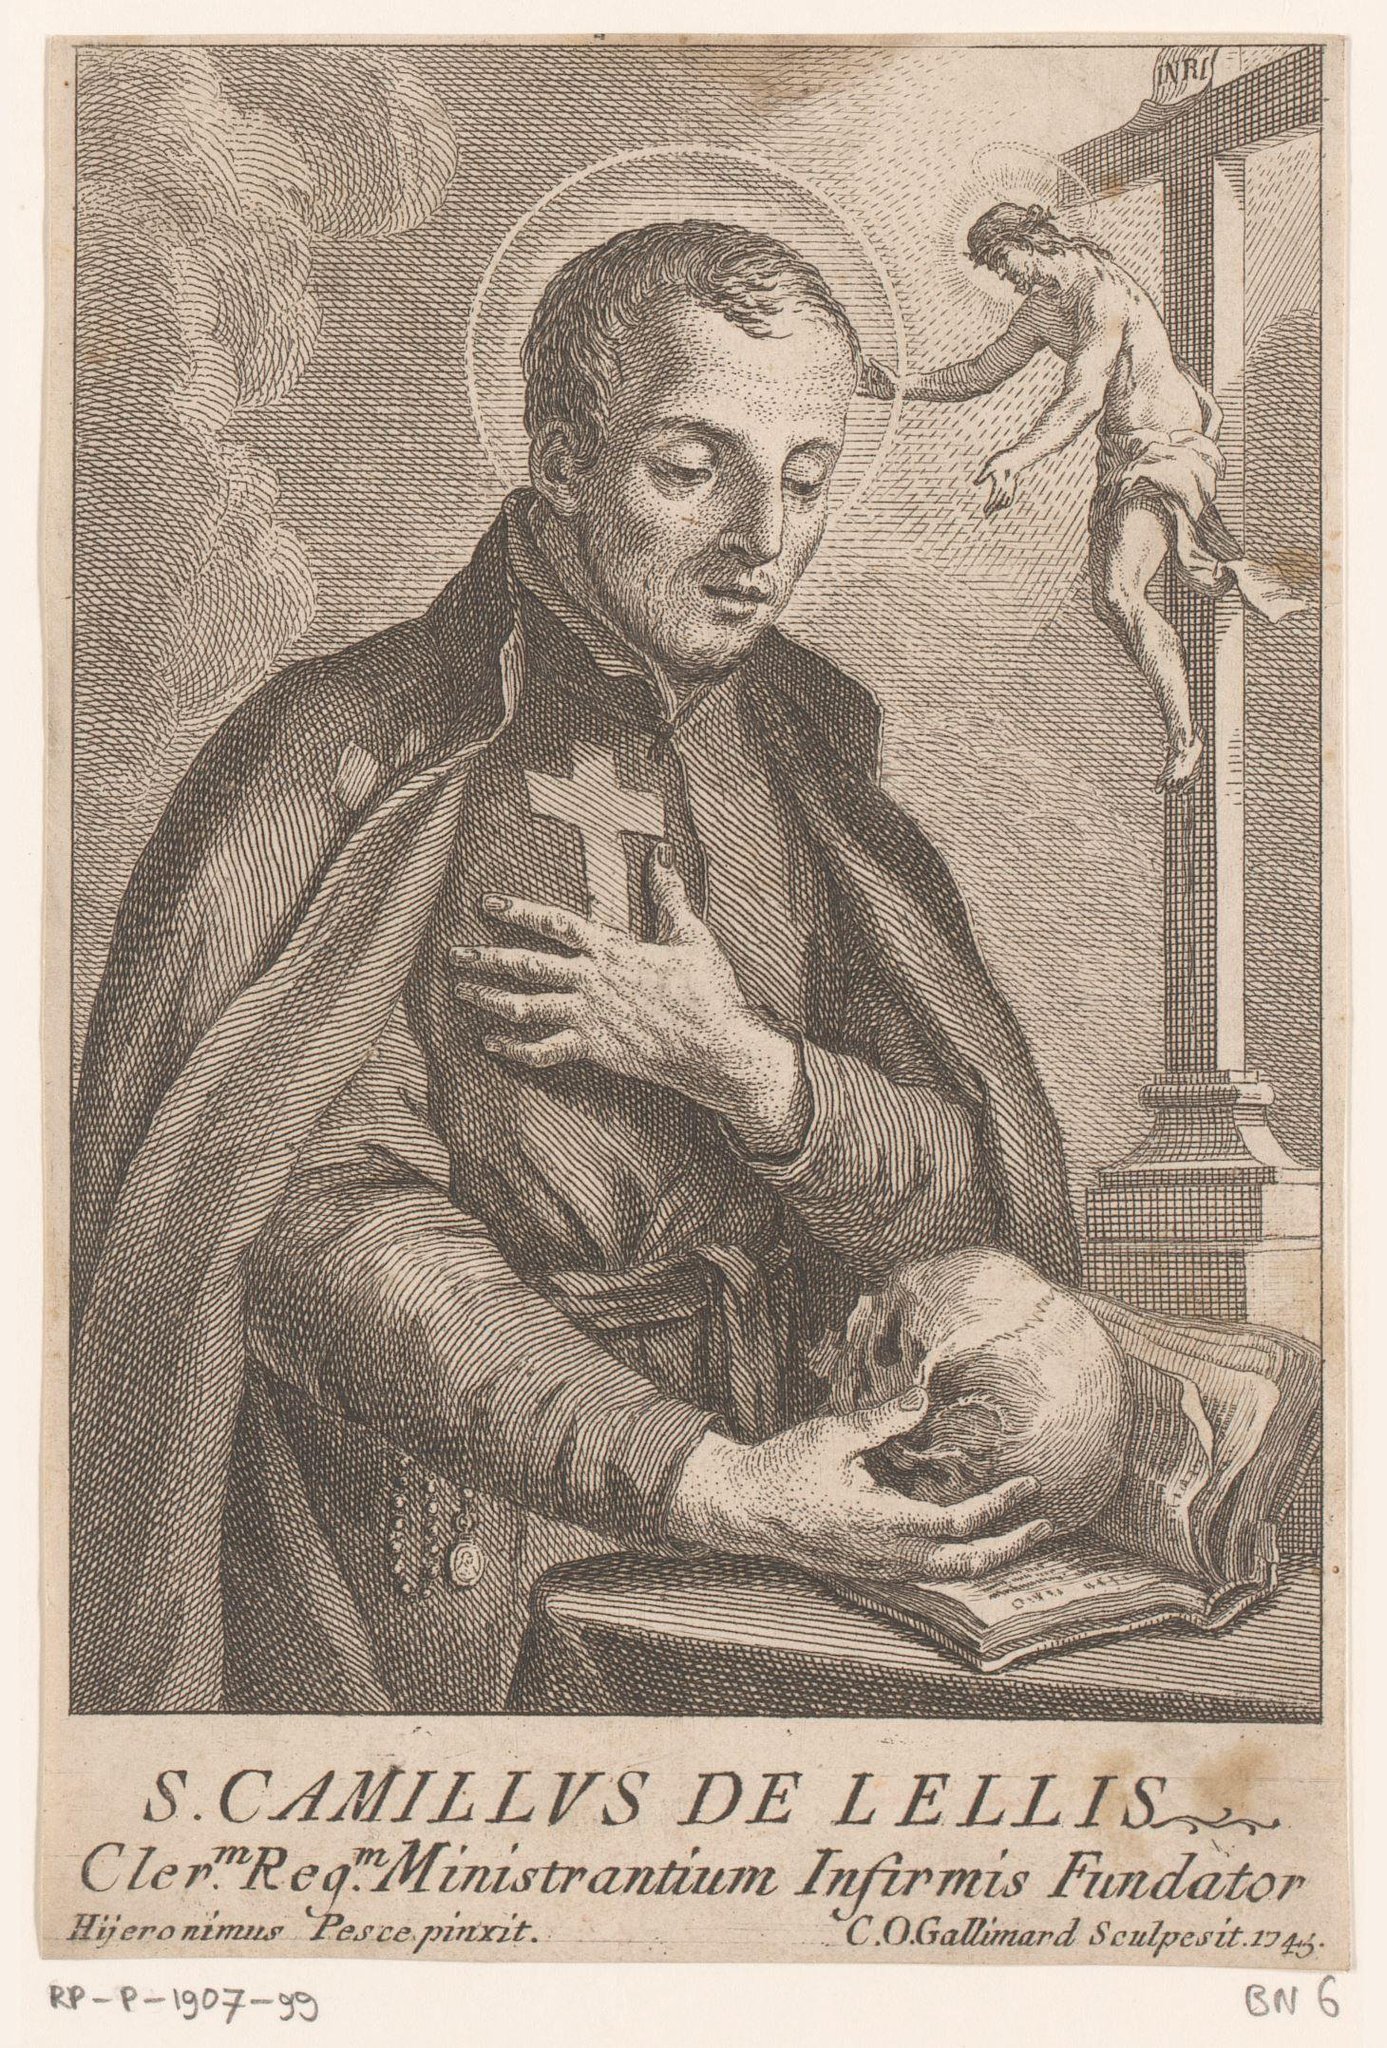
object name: print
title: Heilige Camillus de Lellis in gebed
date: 1743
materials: paper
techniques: engraving, etching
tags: saints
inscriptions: collector's mark: Lugt 2228